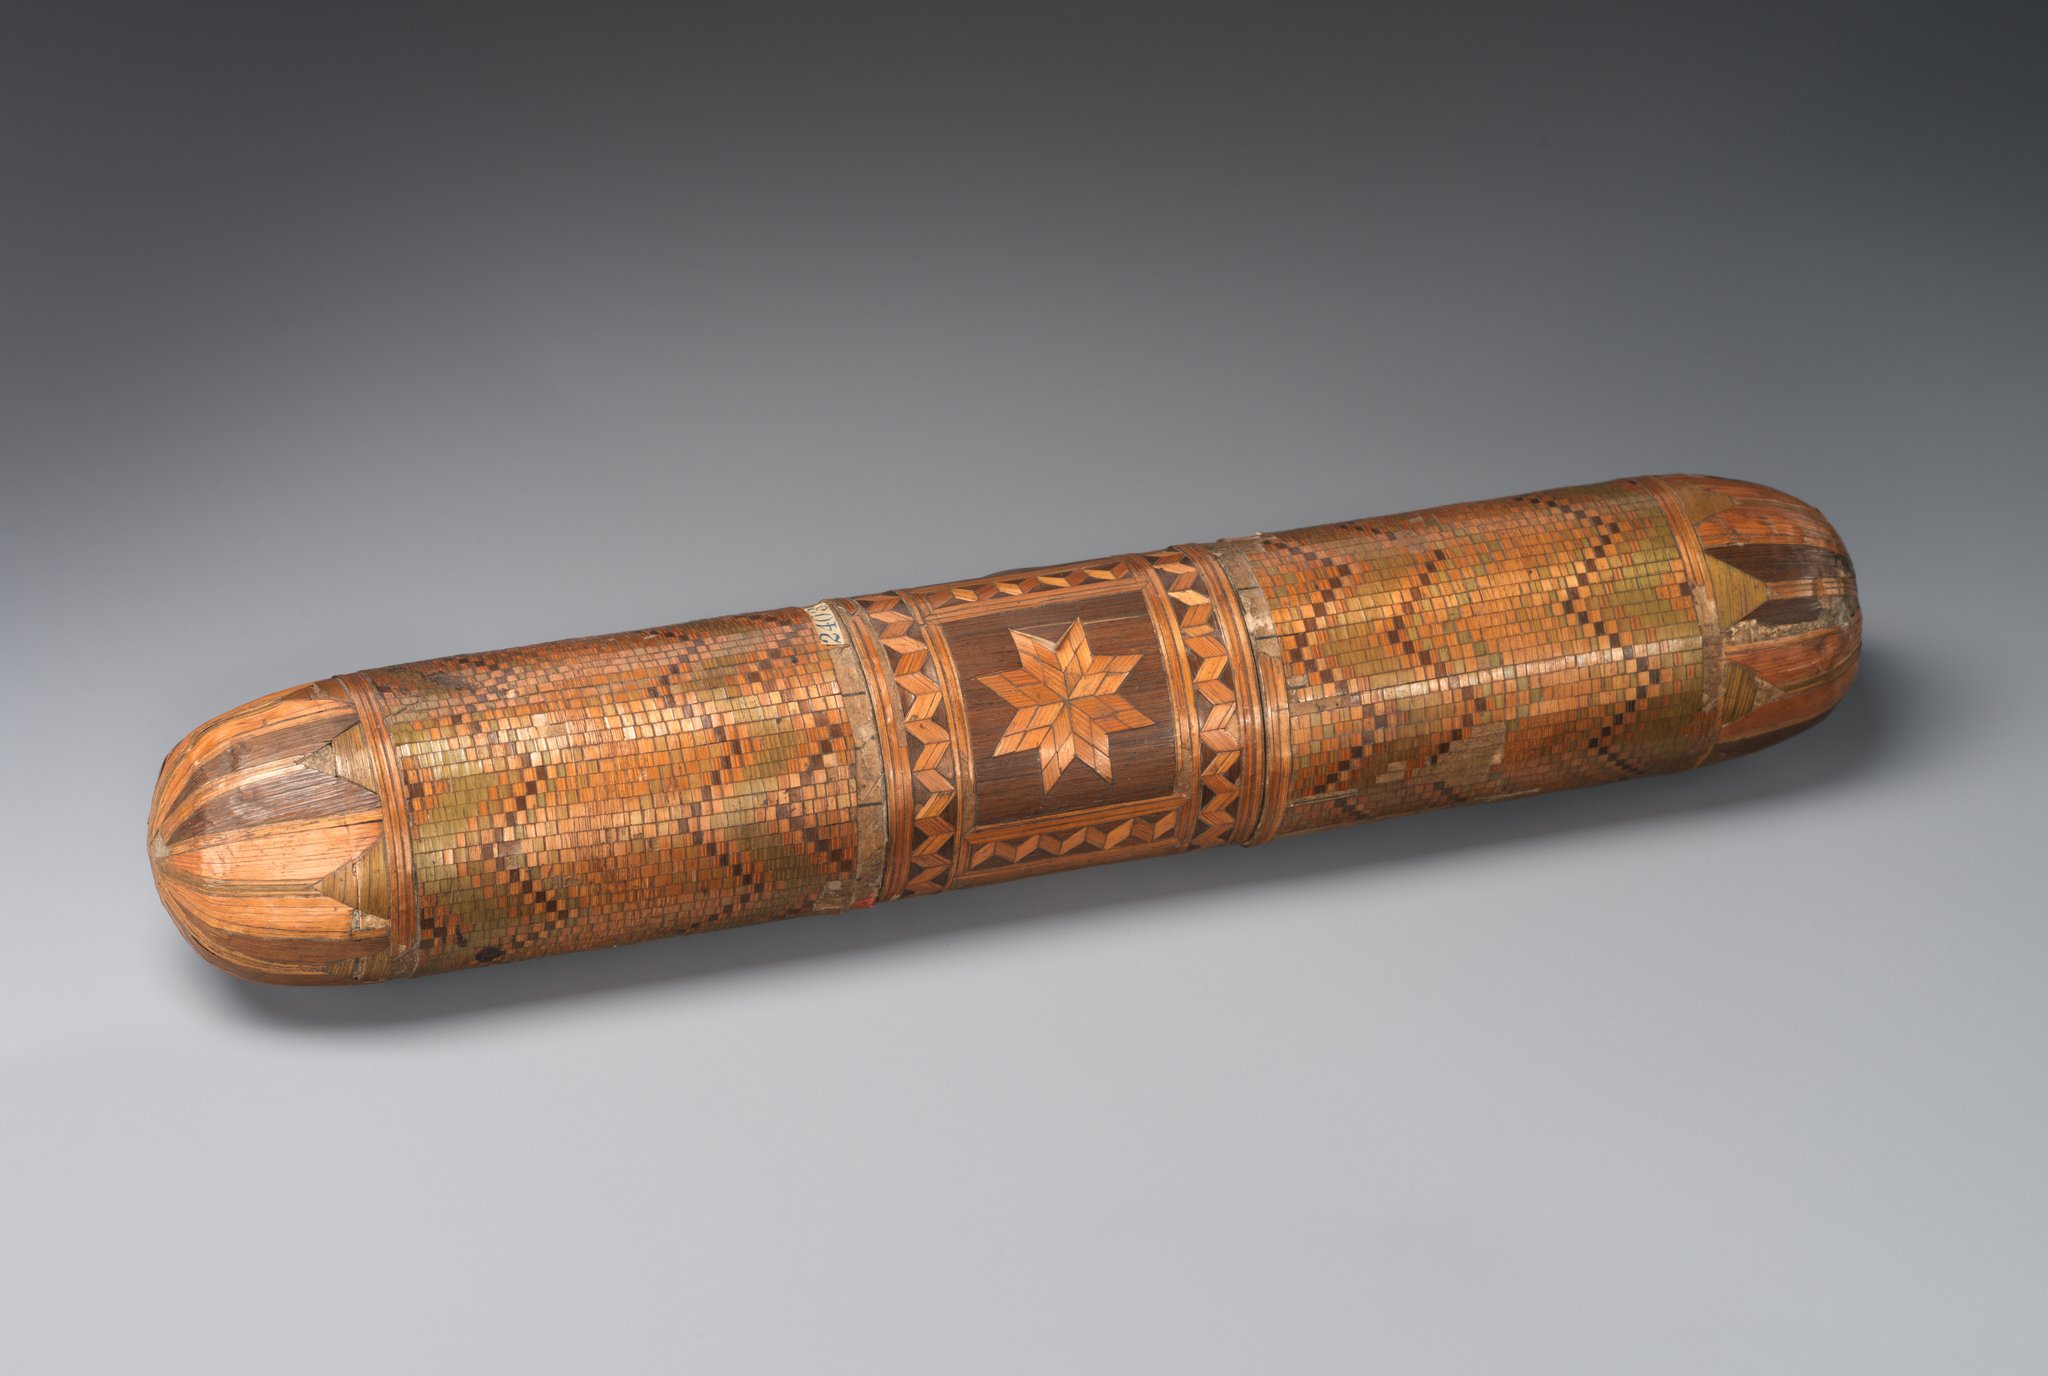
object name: étui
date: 1767-1800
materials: paper, fiber